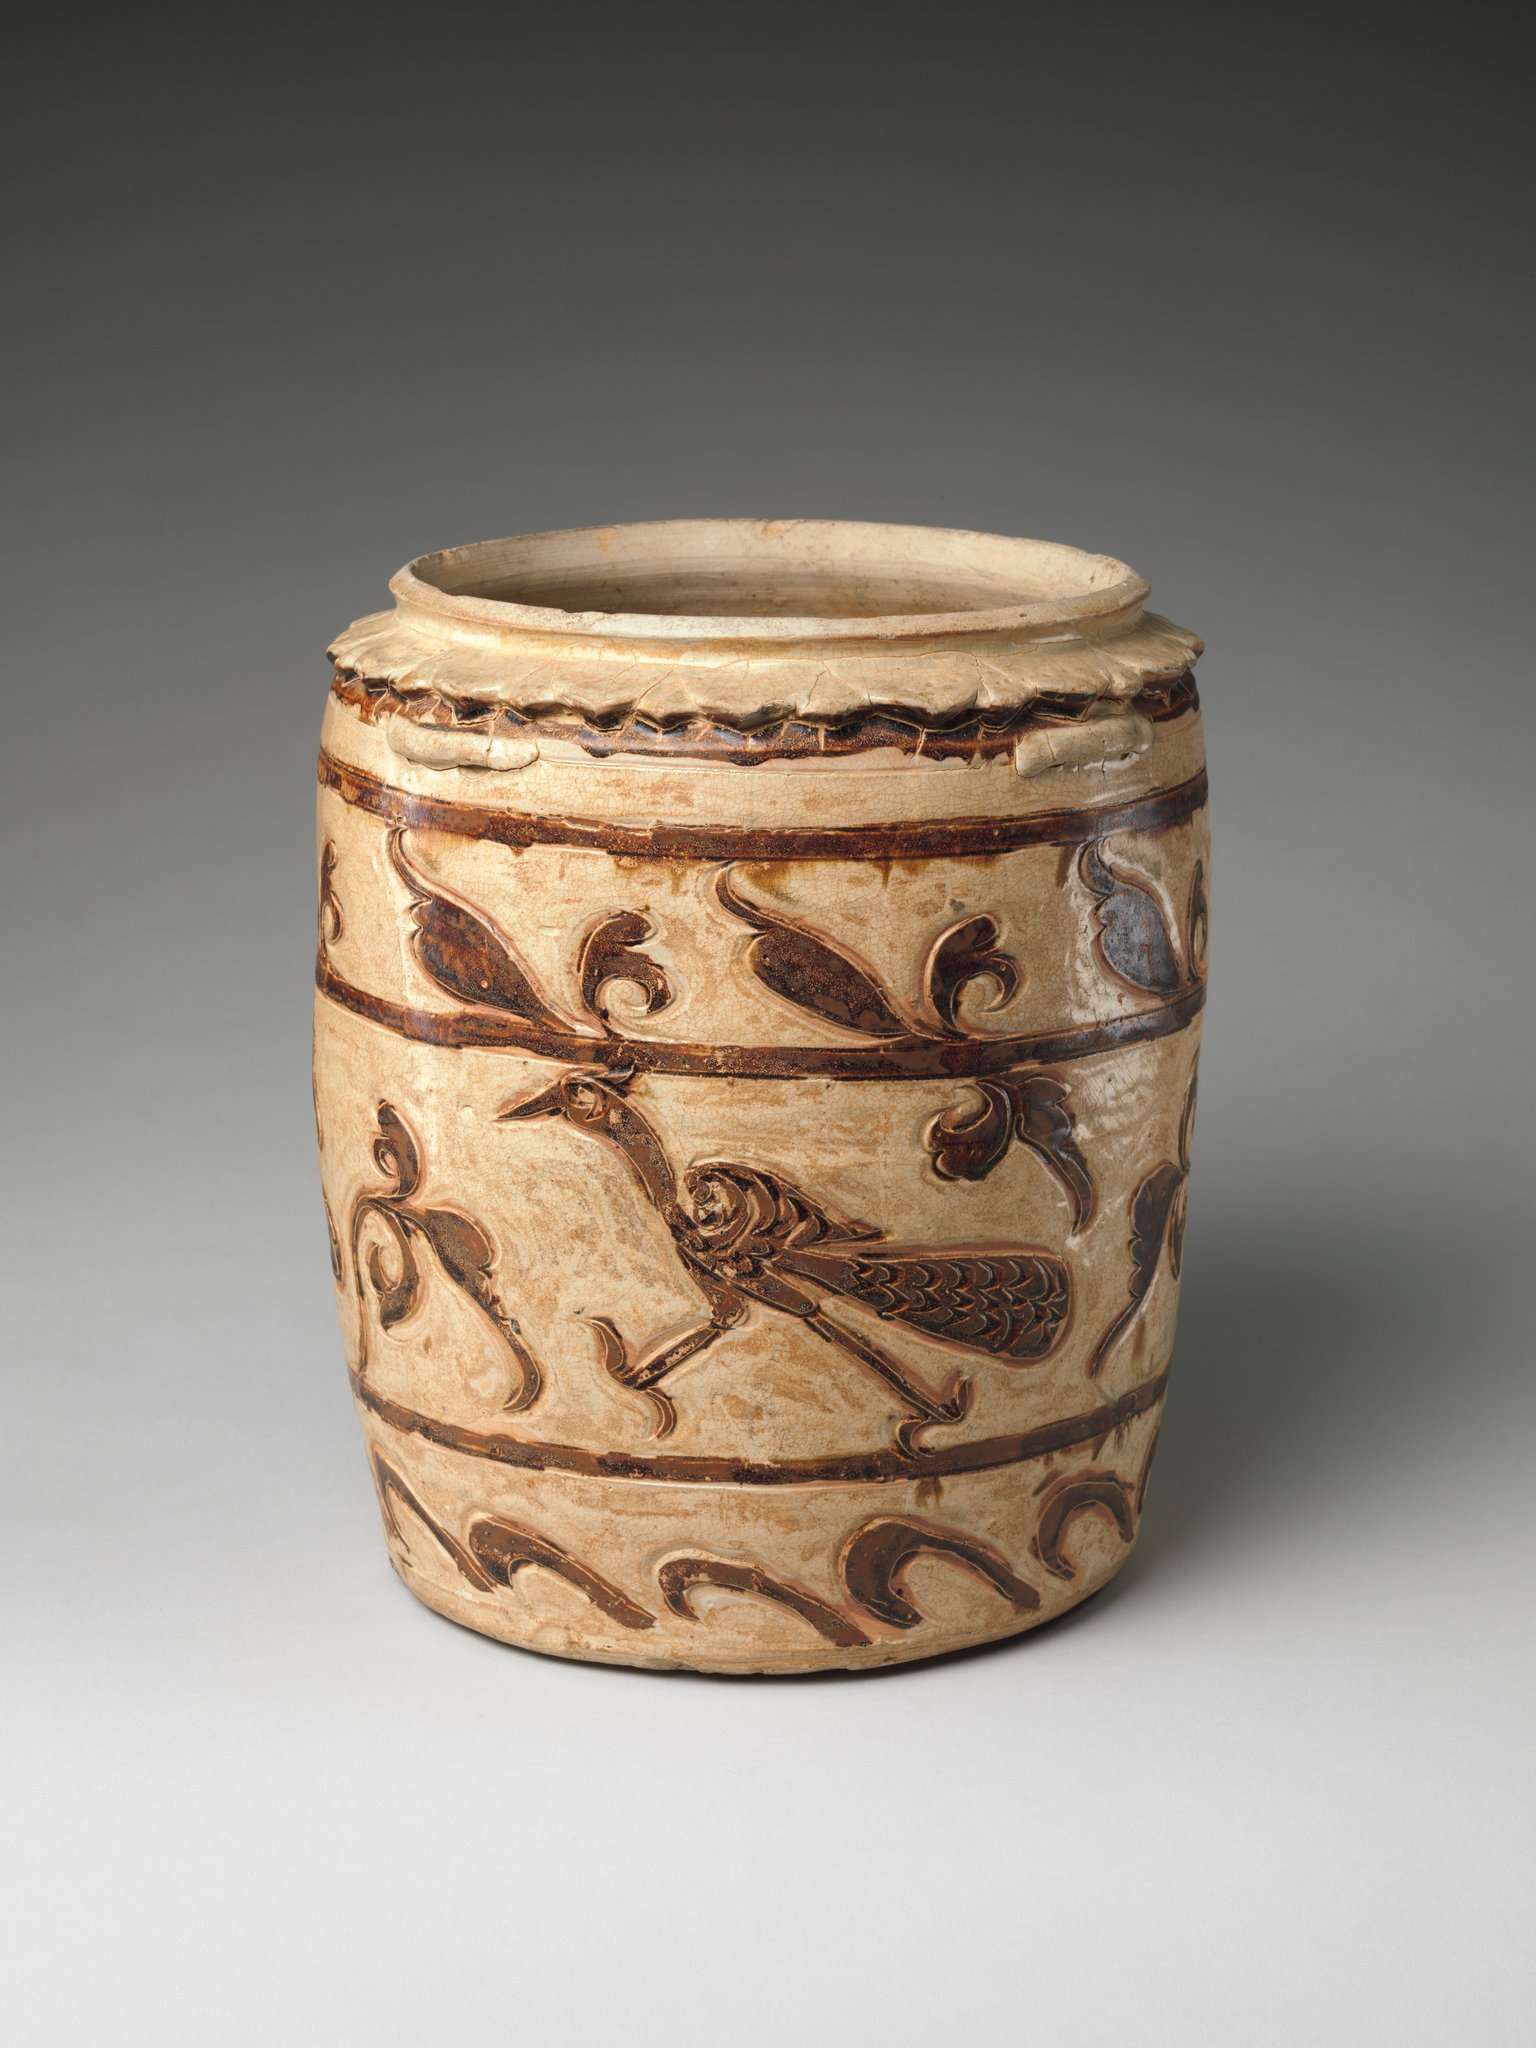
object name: jar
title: Storage Jar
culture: vietnamese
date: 1201-1300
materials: stoneware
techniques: glazing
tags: birds,leaves